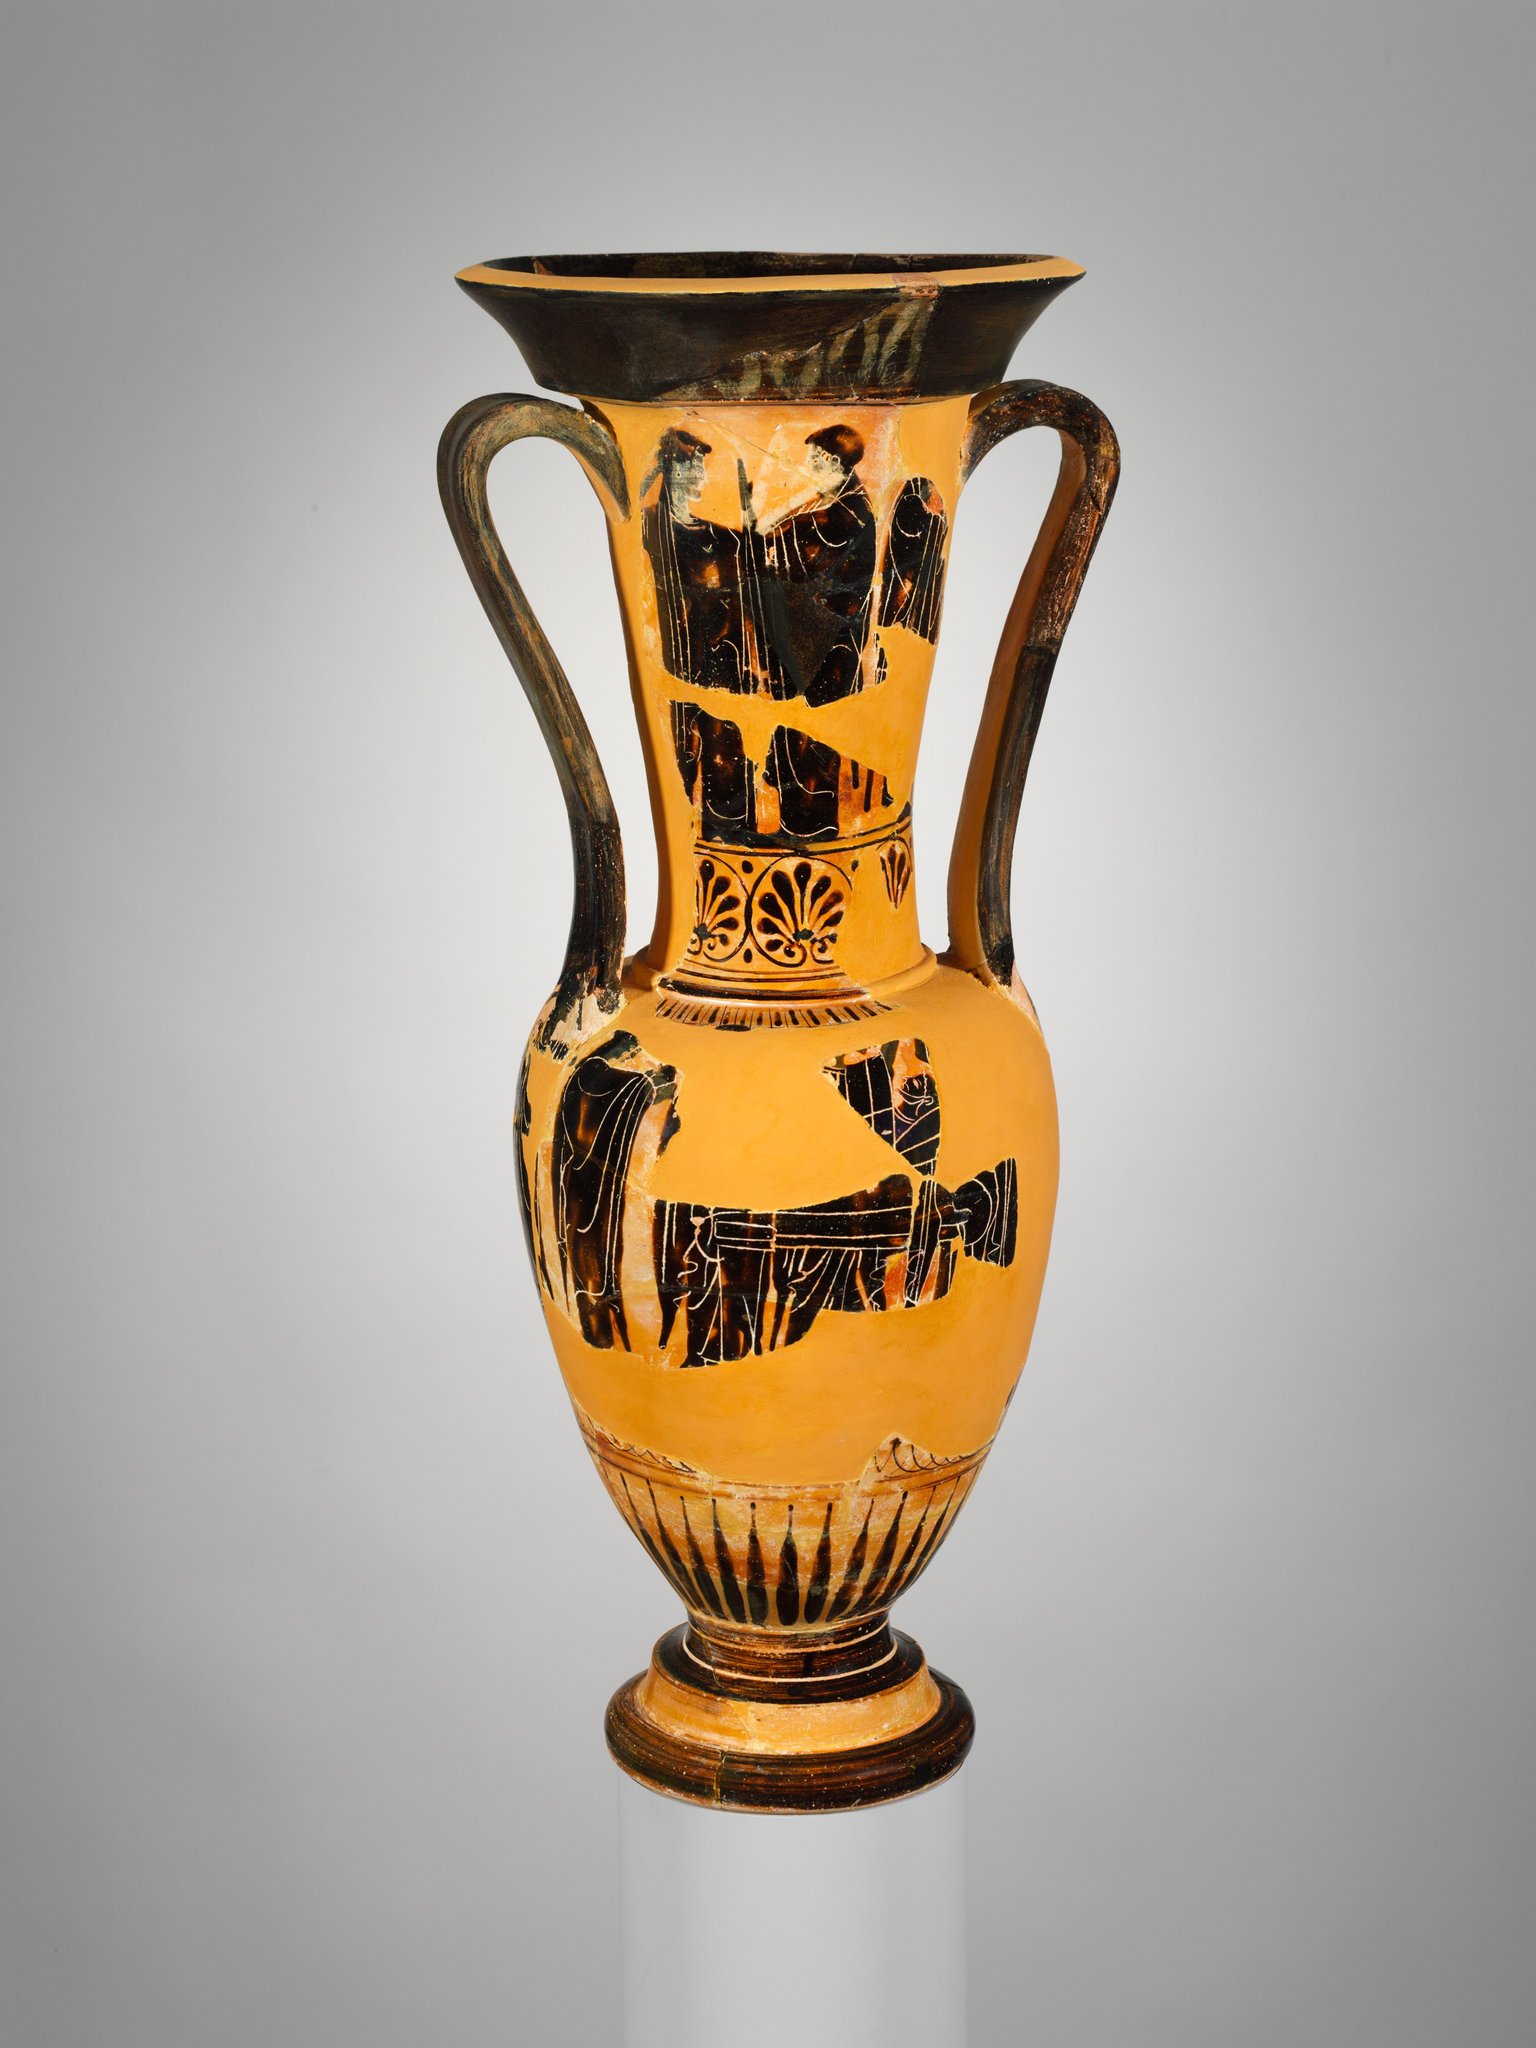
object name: loutrophoros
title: Terracotta loutrophoros (ceremonial vase for water)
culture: greek, attic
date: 534-501 BCE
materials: terracotta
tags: men,women